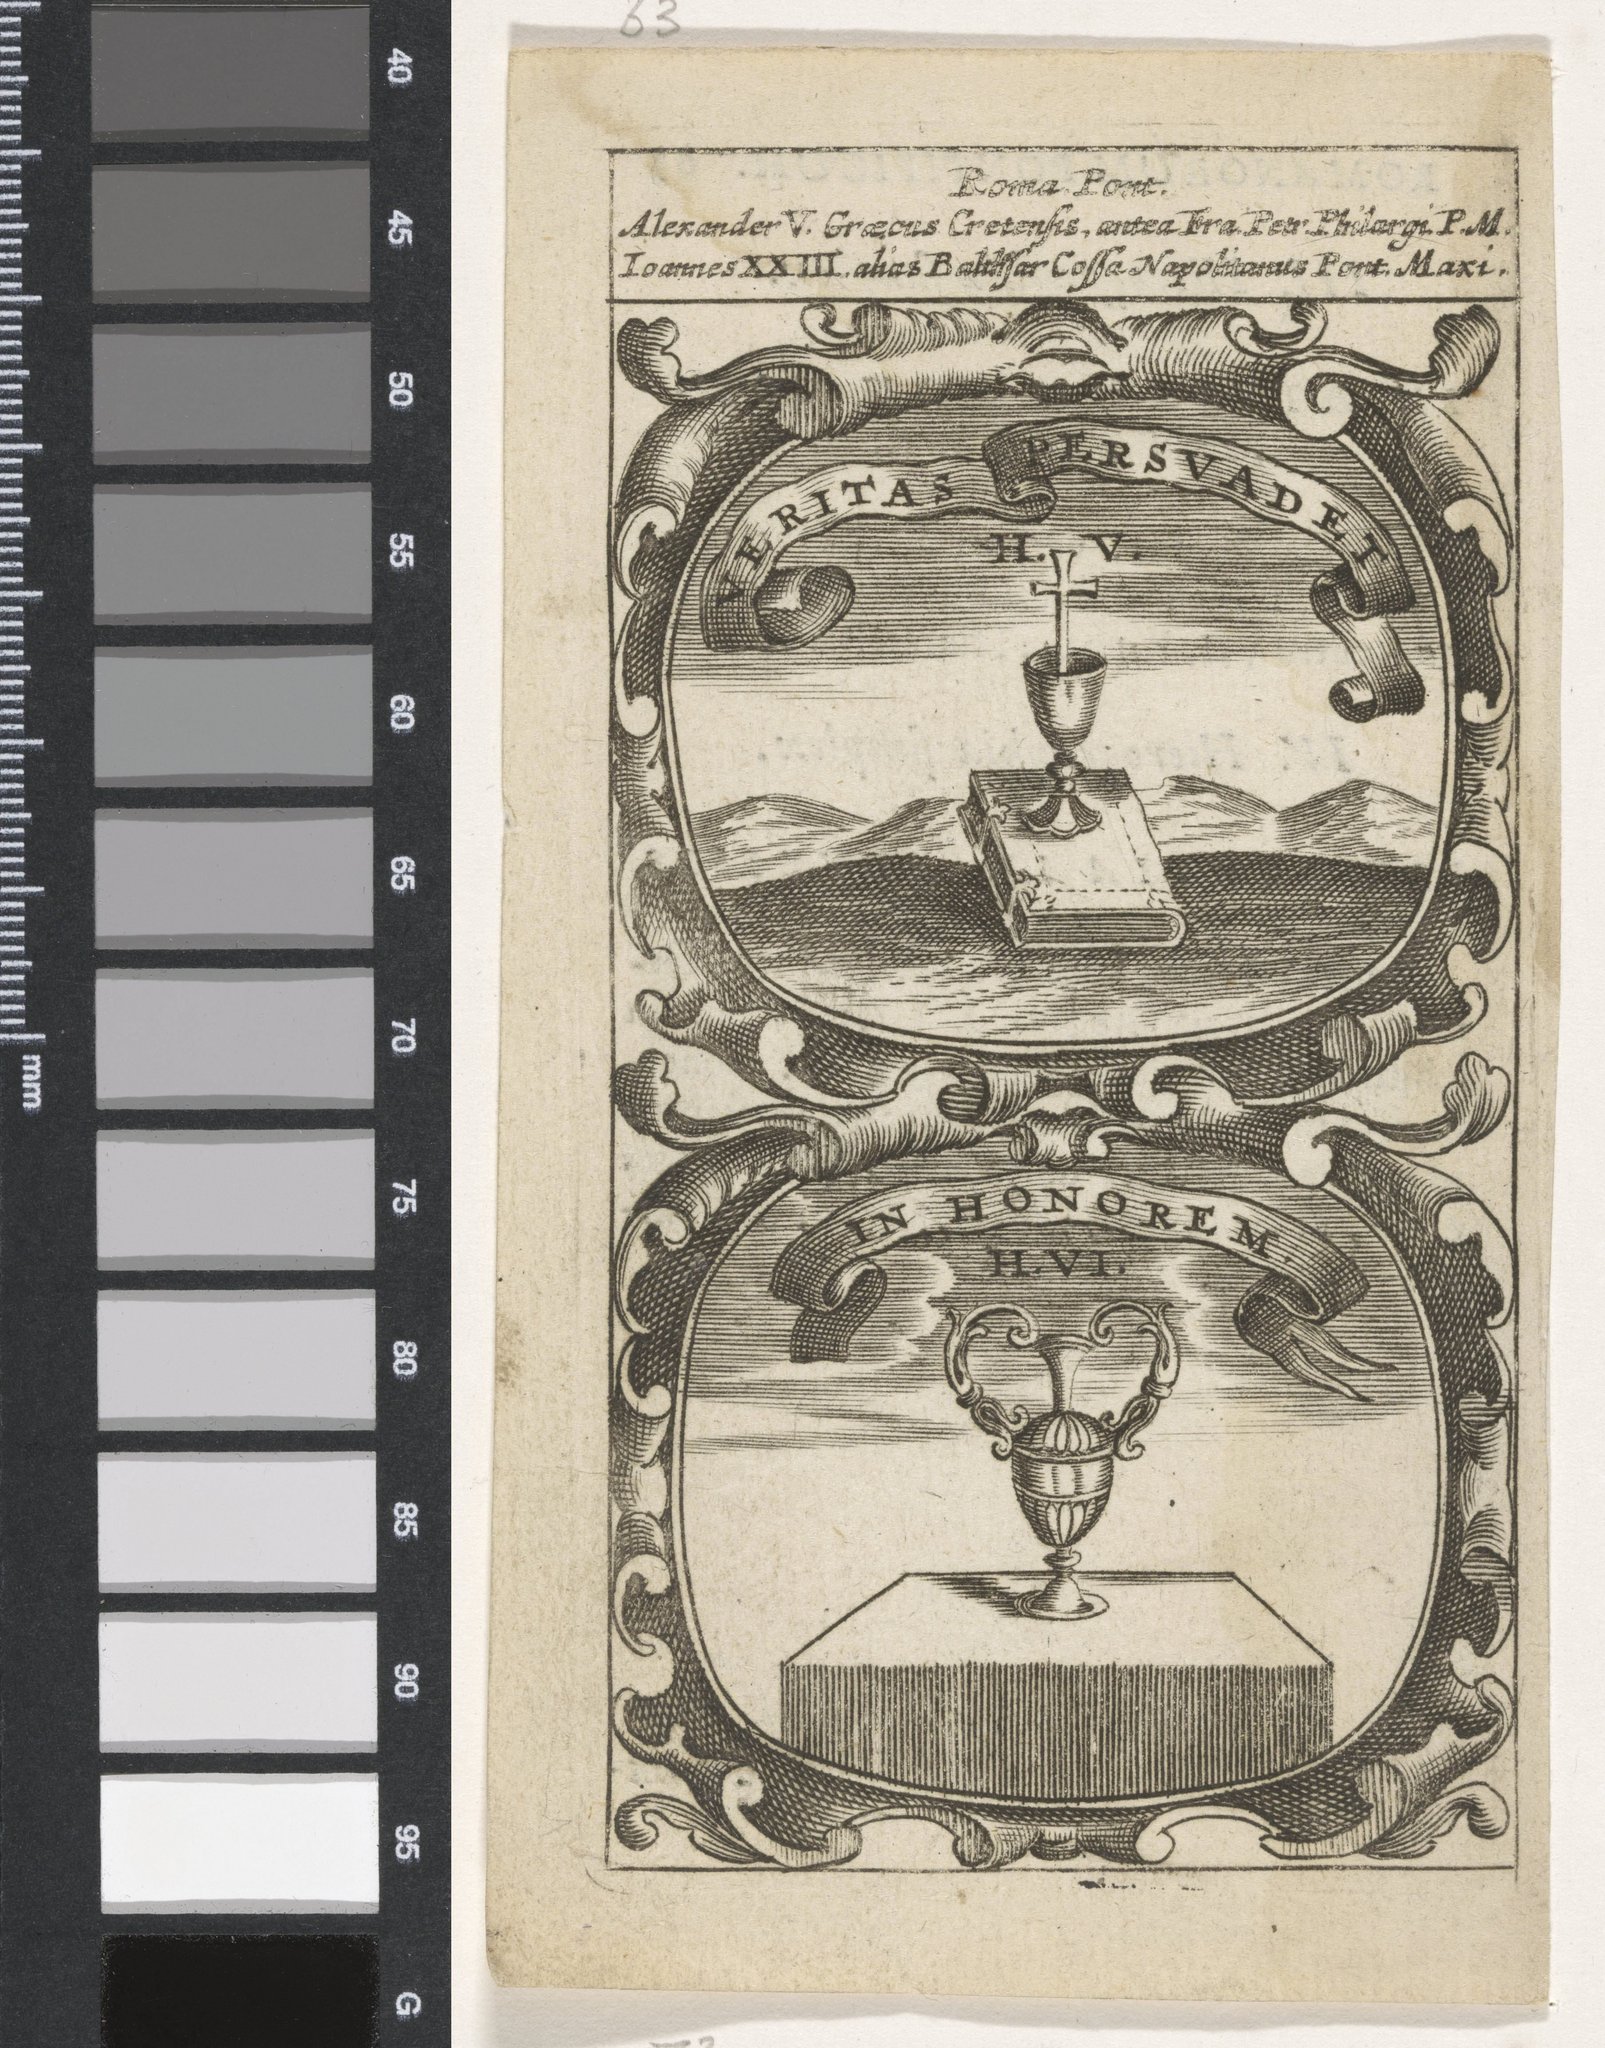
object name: print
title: Veritas Persvadet / In Hornorem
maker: Anonymous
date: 1666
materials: paper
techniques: engraving, letterpress printing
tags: clergyman, chalice, book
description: Pagina uit Jacob Typotius, Symbola Divina & Humana Pontificum Imperatorum Regum. Arnhem, J.F. Hagen, 1666 of uit de titeluitgave van 1669 of 1679. Het werk van Typotius werd voor het eerst uitgegeven in 1601 met prenten van Aegidius Sadeler.